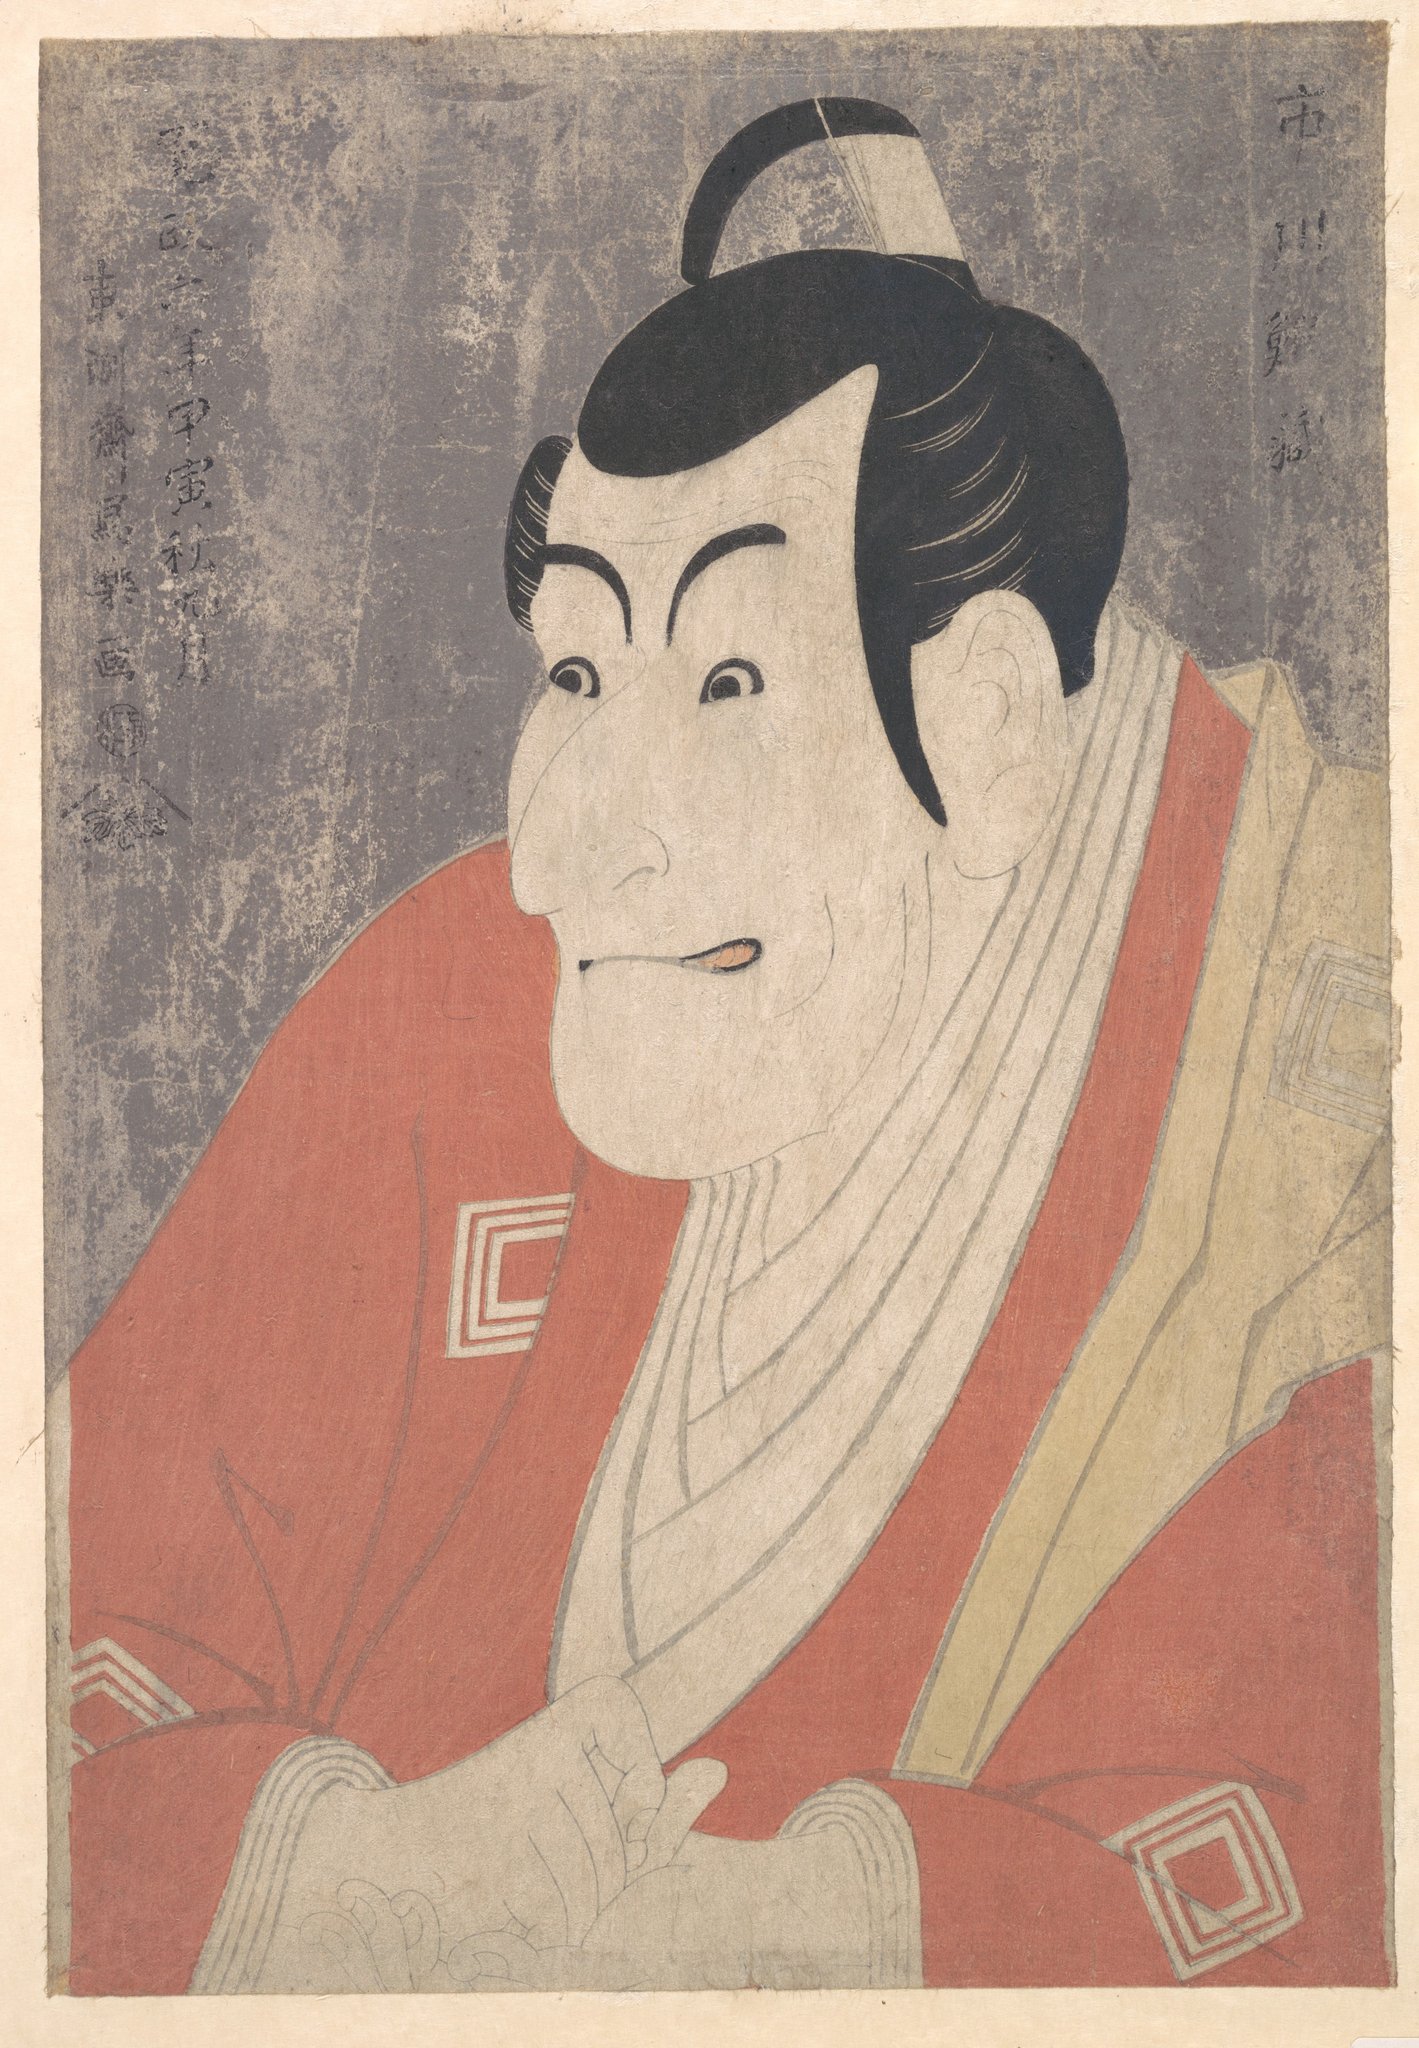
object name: print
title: Ichikawa Ebizō IV as Takemura Sadanojō in the Play Koinyōbō Somewake Tazuna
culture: japanese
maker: tōshūsai sharaku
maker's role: artist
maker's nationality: japanese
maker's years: 1794-1795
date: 1794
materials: ink, mica, paper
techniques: woodblock print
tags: men,actors